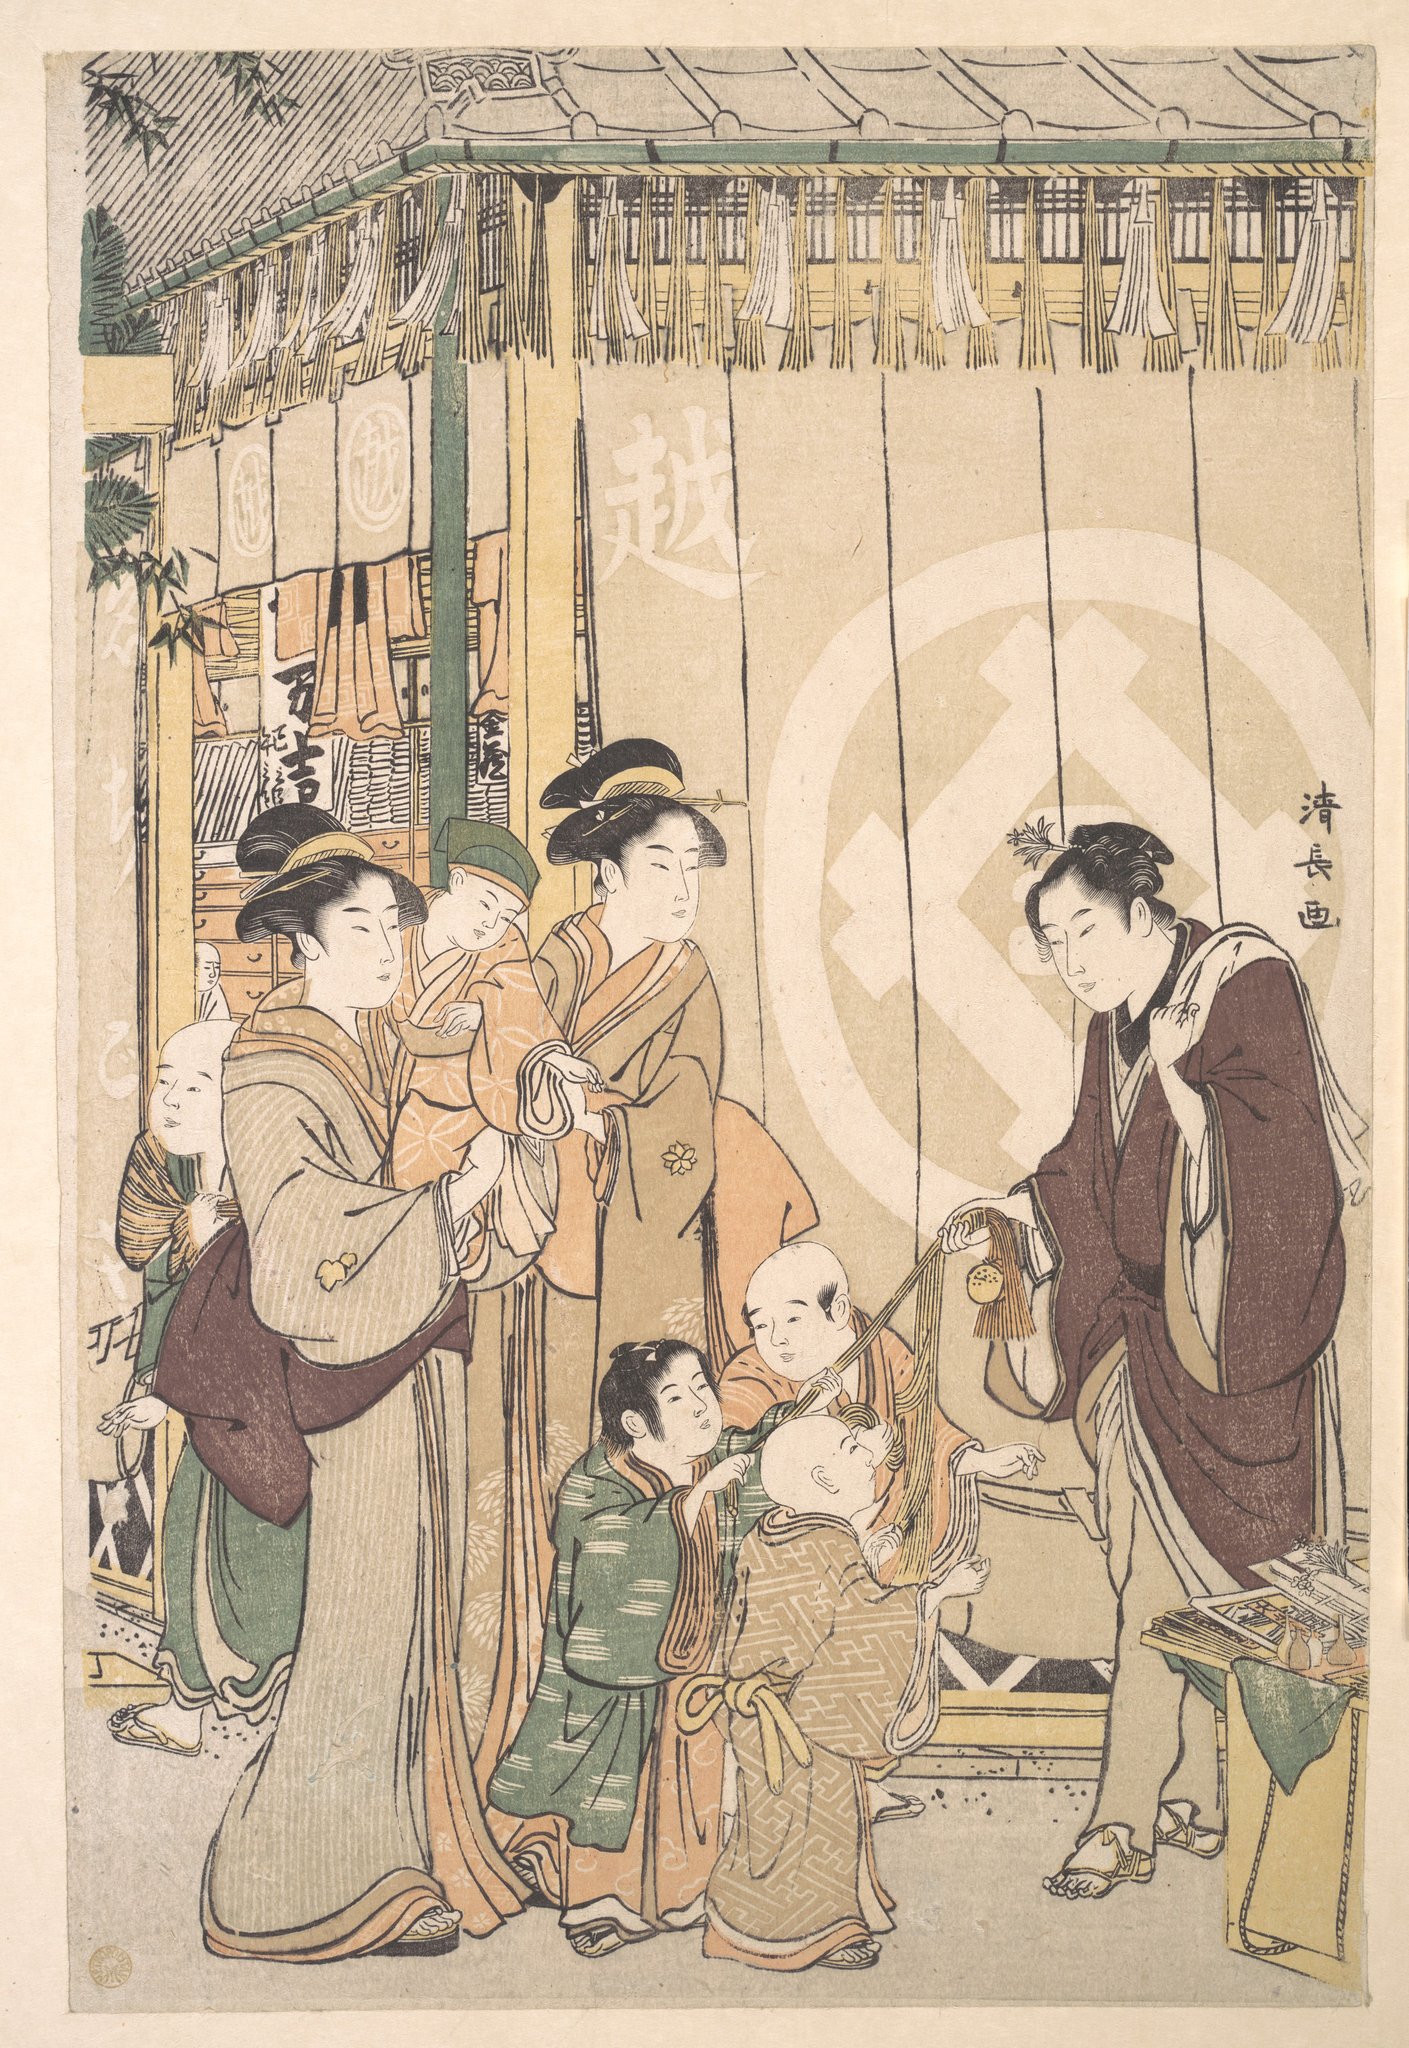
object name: woodblock print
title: Group before the Echigo-ya Dry-goods Shop on New Year's Day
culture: japanese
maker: torii kiyonaga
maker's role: artist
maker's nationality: japanese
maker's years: 1752-1815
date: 1789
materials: ink, paper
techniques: nishiki e, woodblock print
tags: children,women,shops